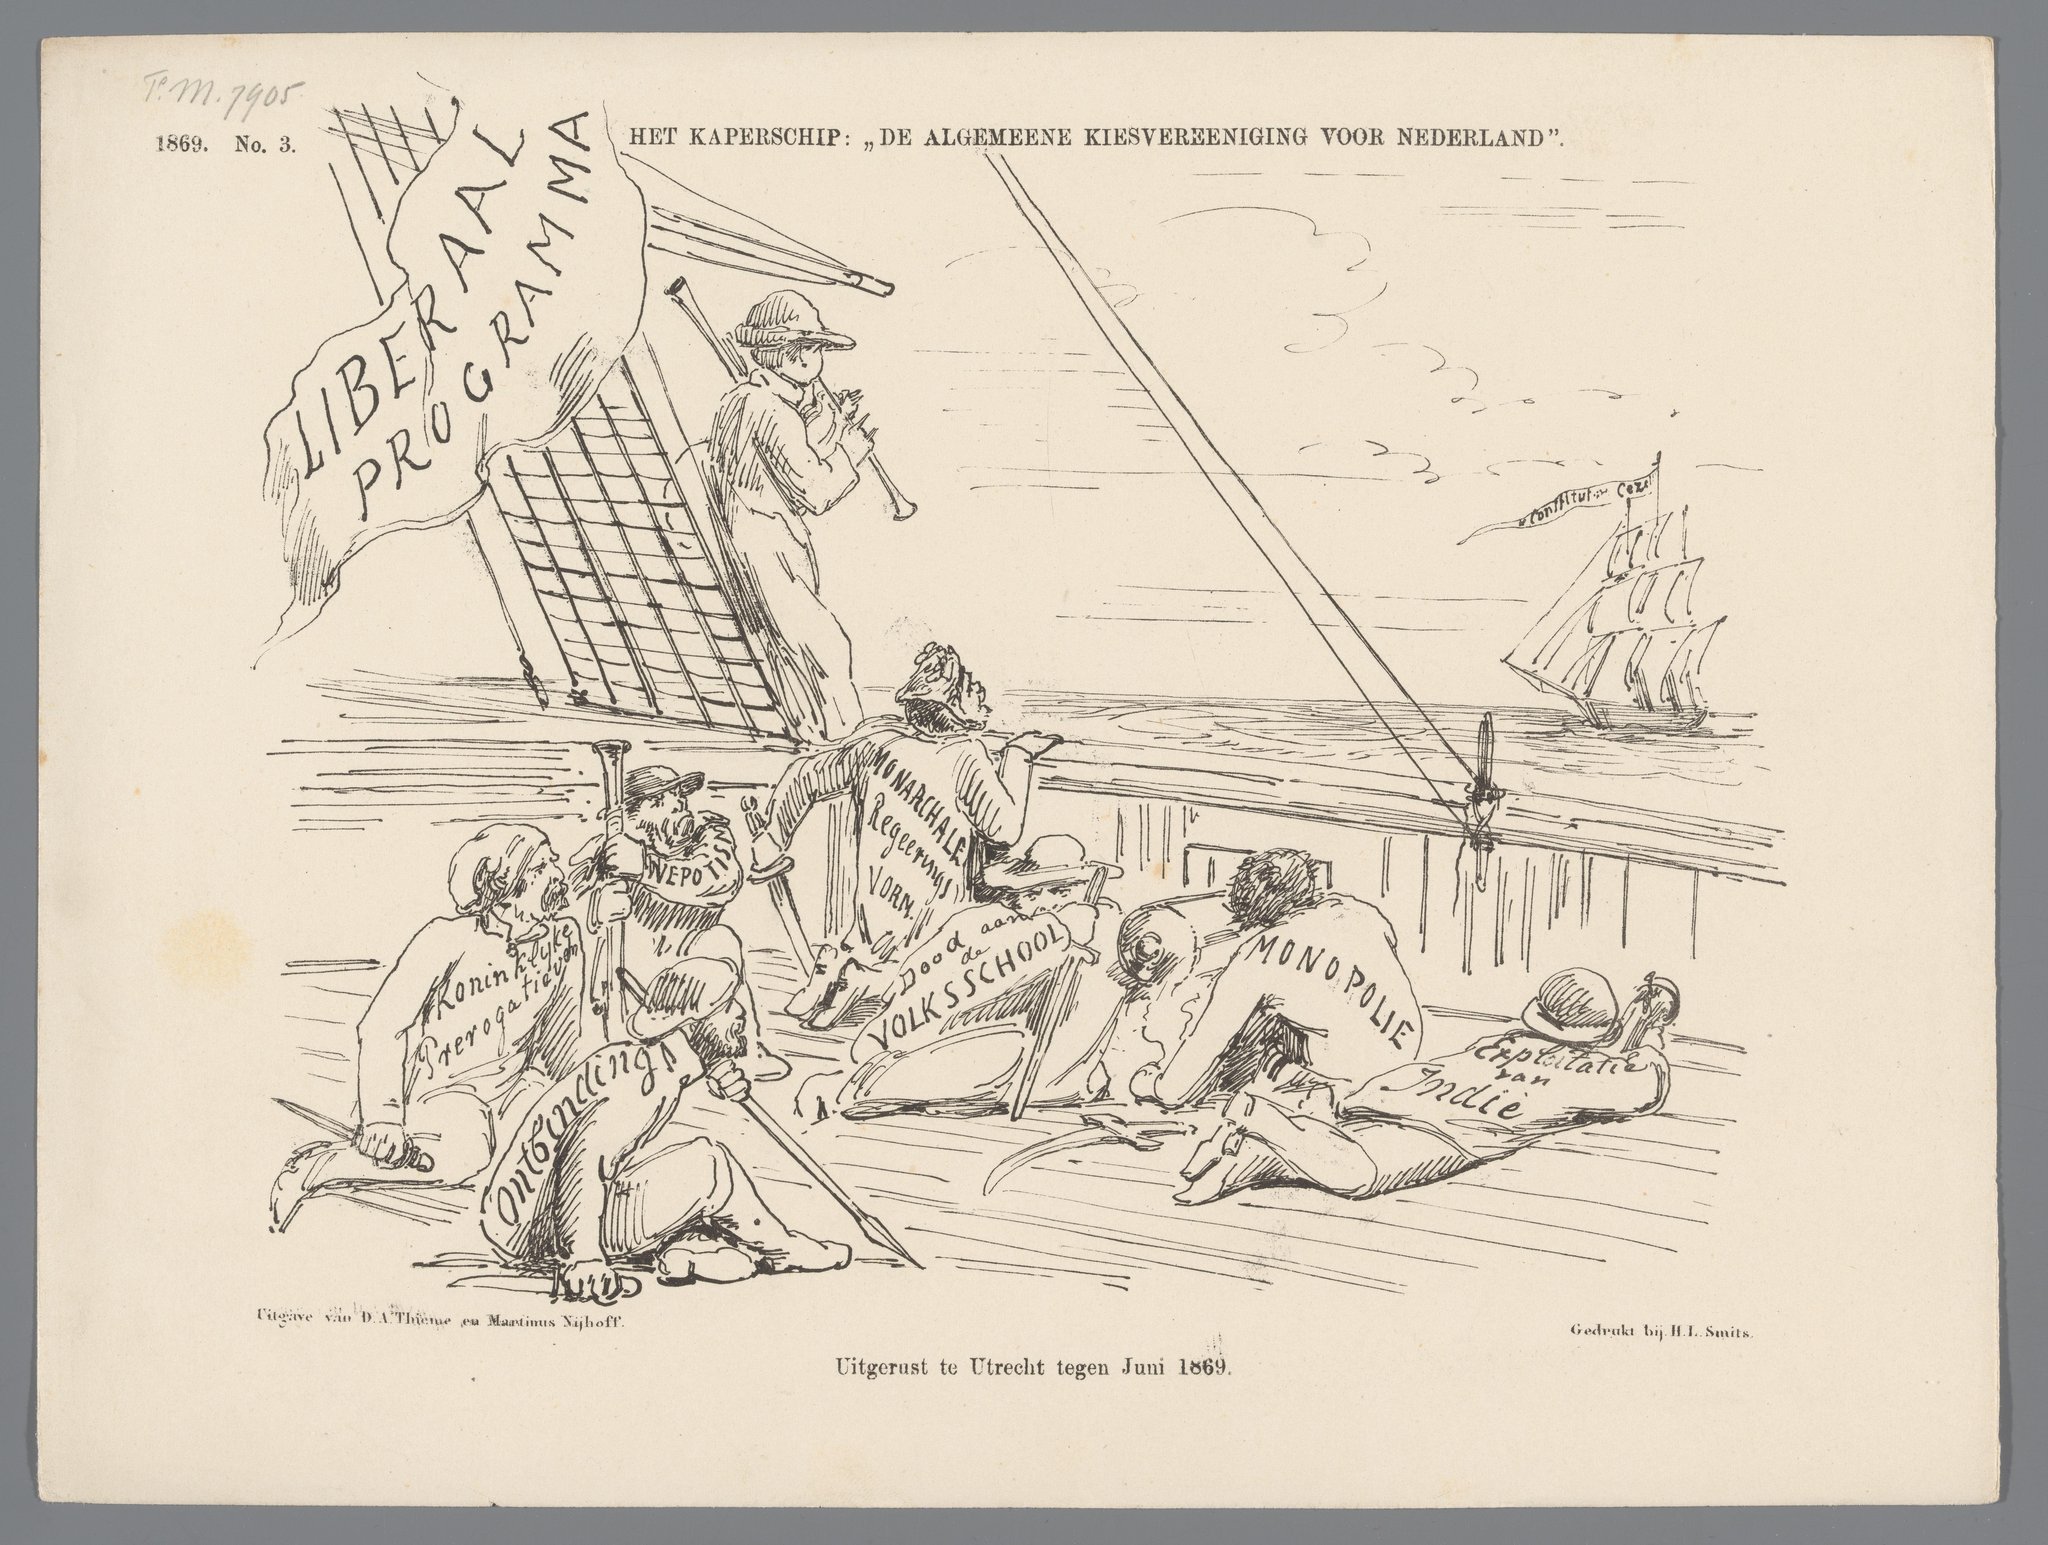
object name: cartoon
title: Spotprent op de Nederlandsche Centrale Kiesvereeniging te Utrecht, 1869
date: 1869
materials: paper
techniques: lithograph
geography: netherlands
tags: pirate(ship)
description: Spotprent op de Nederlandsche Centrale Kiesvereeniging te Utrecht. Een kaperschip varend onder 'Liberaal Programma'. Plaat verschenen bij het weekblad De Nederlandsche Spectator, nr. 1869.